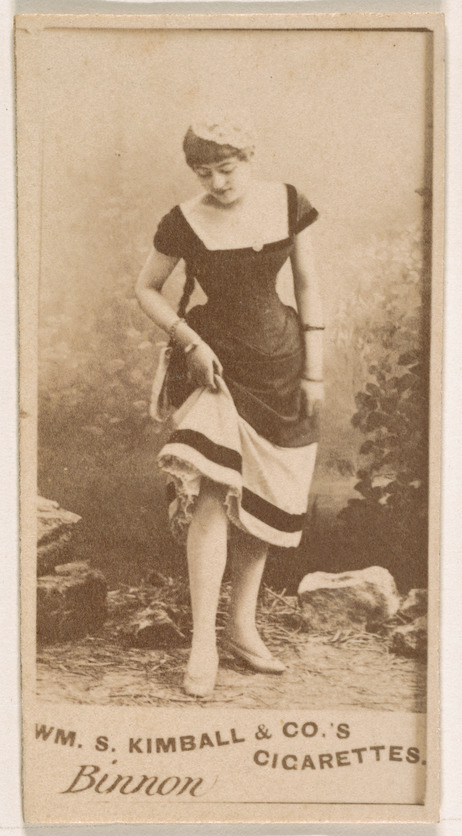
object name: photograph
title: Miss Binnon, from the Actresses series (N203) issued by Wm. S. Kimball & Co.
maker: william s. kimball & company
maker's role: publisher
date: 1889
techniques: color lithograph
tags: portraits,women,actresses